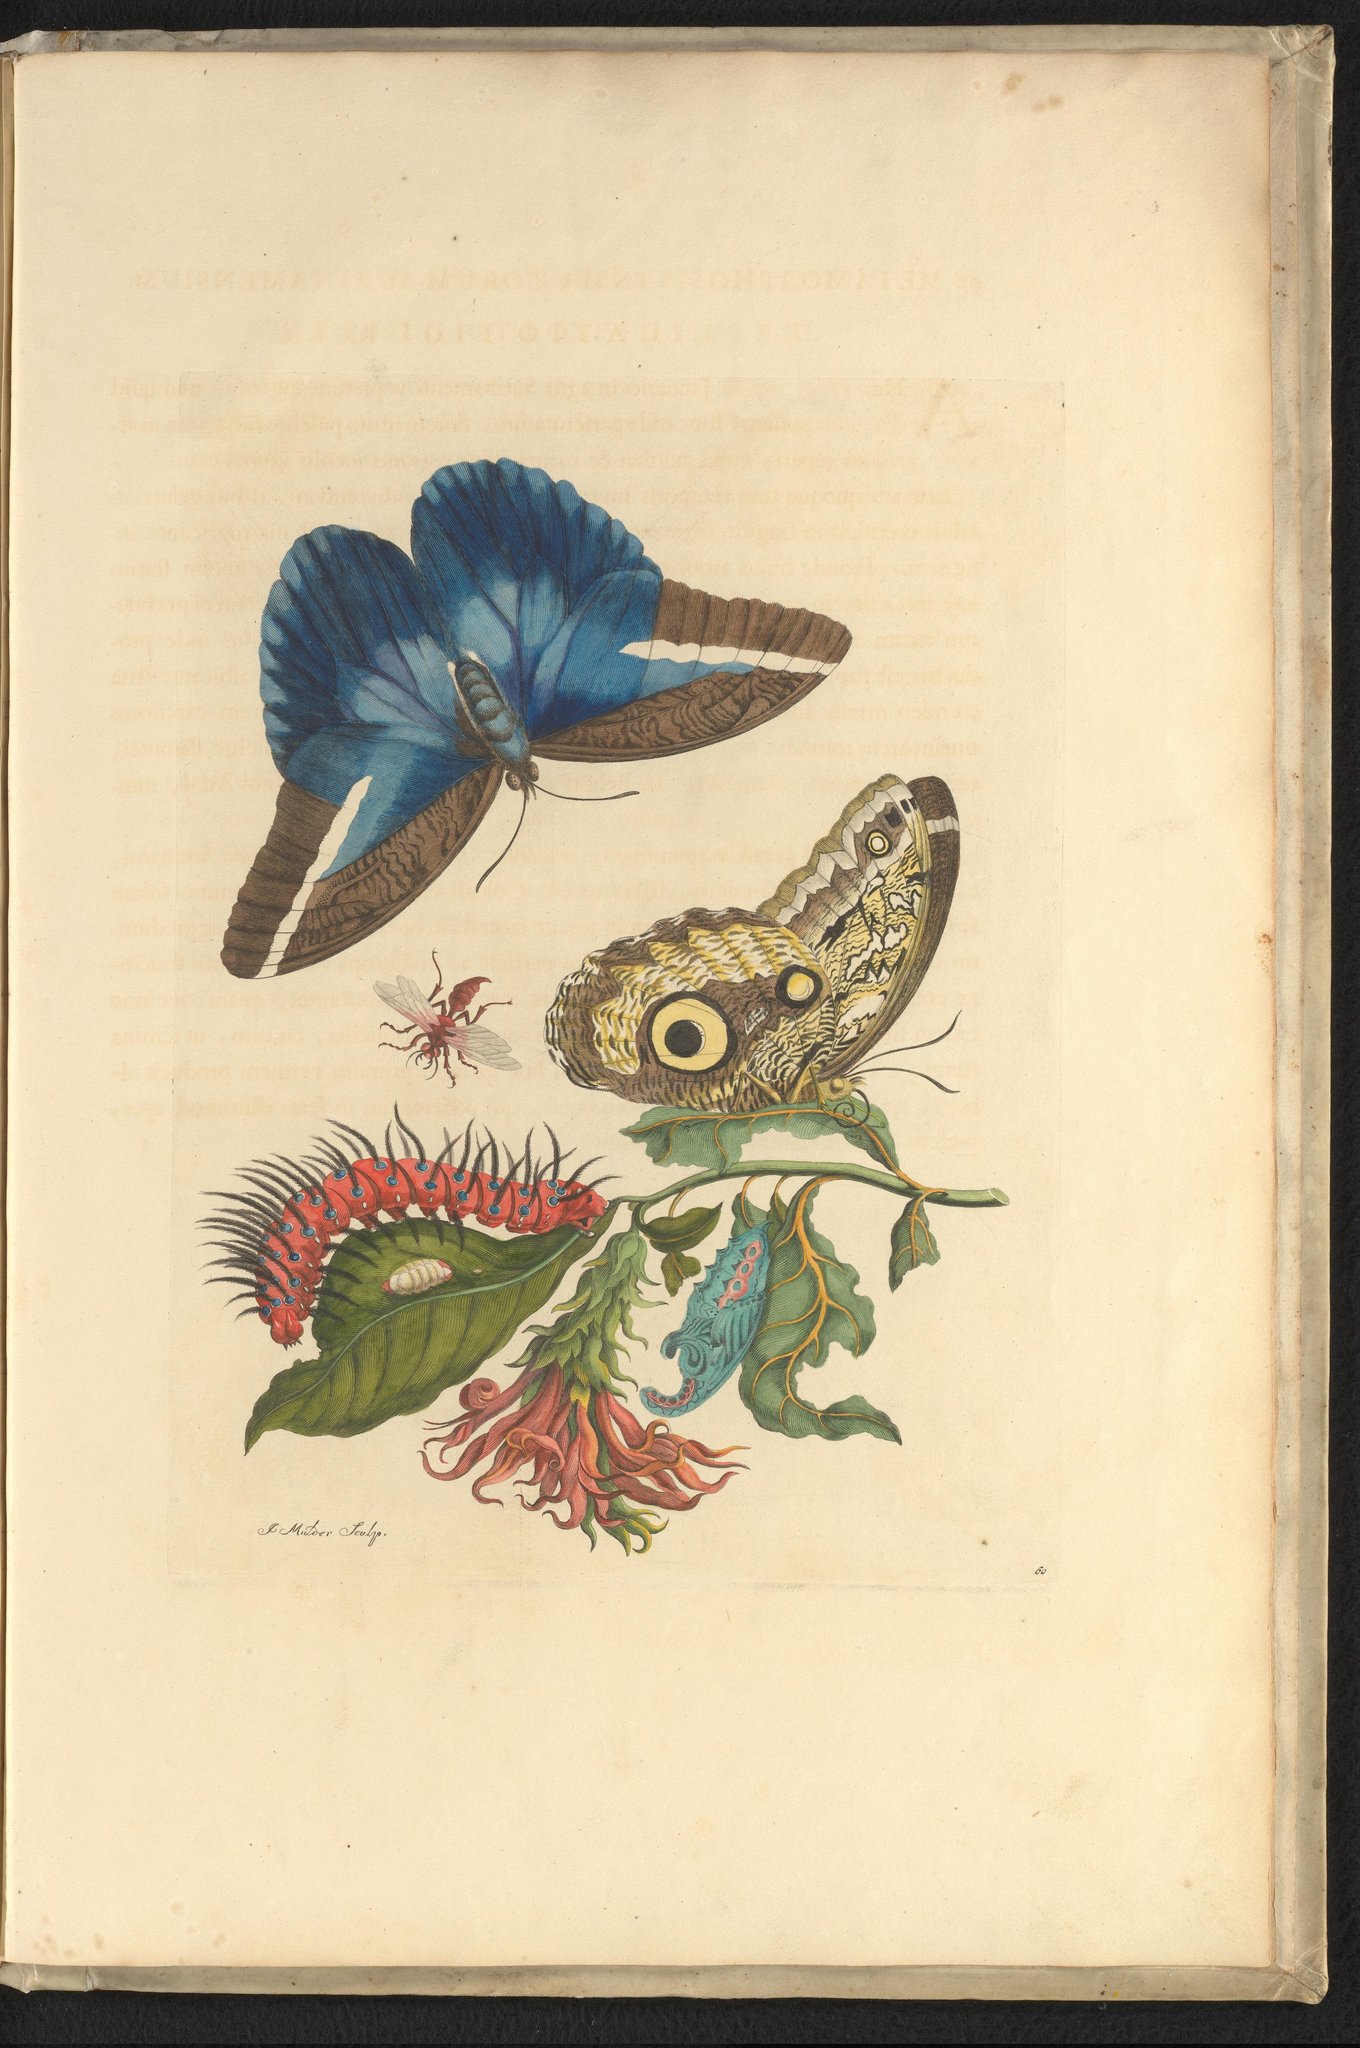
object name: print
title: Plant (Pachystachys coccinea) met twee vlinders, veldwesp, rups, pop en larve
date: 1705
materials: paper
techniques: etching, hand coloring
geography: amsterdam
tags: plants (in general), insects: pupa, insects: wasp, insects: butterfly, insects: caterpillar, suriname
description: Rechtsonder genummerd: 60. Prent maakt deel uit van een boek.